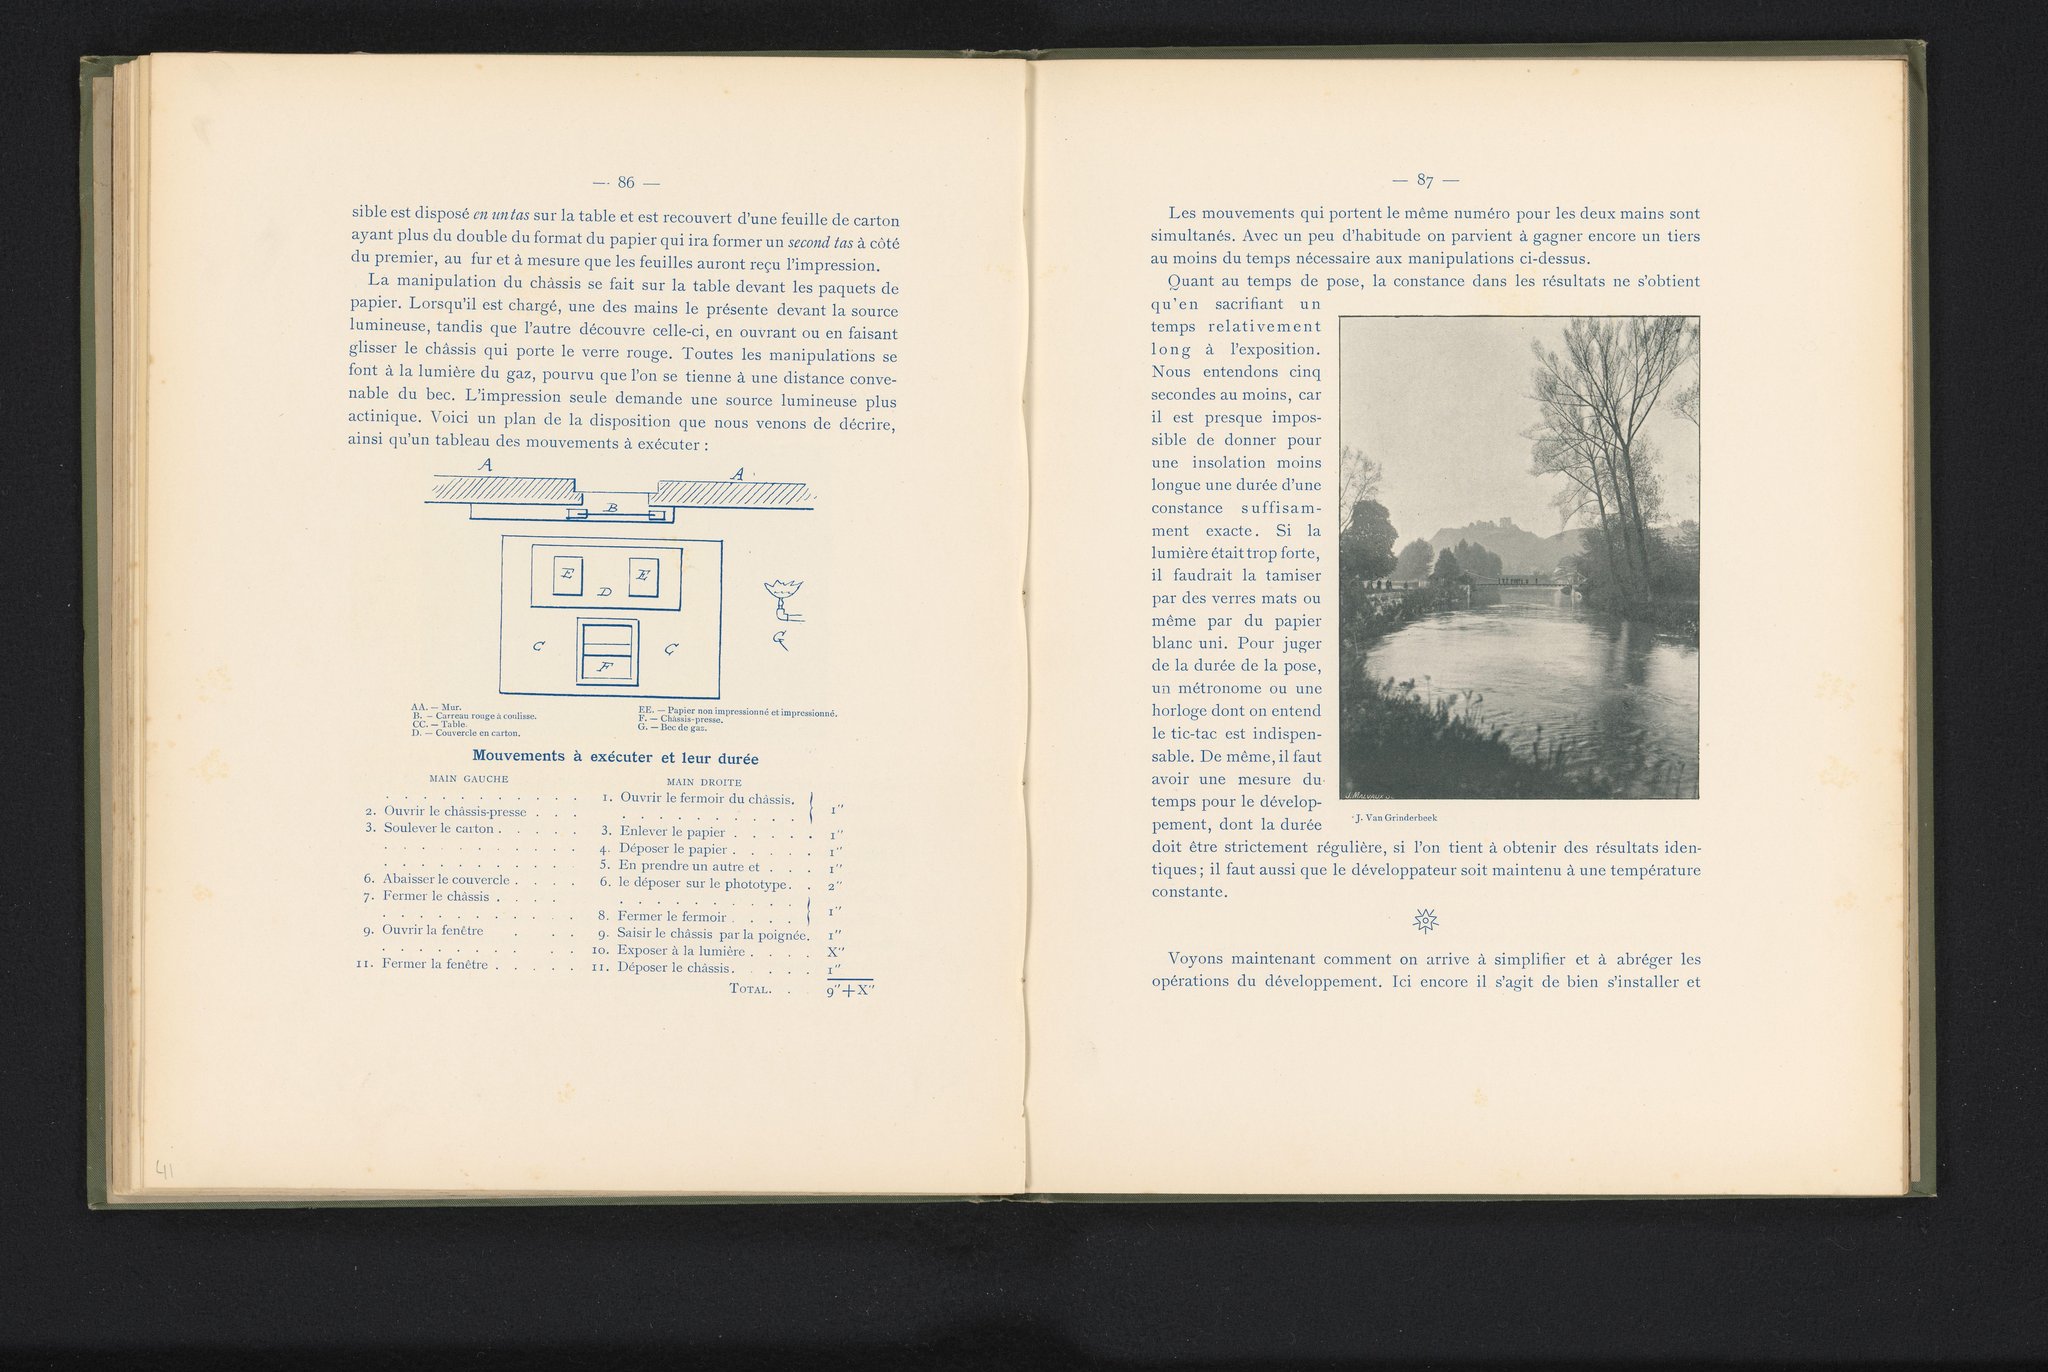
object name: page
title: Landschap met rivier en mensen op een brug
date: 1893-1898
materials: paper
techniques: autotype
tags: river, bridge